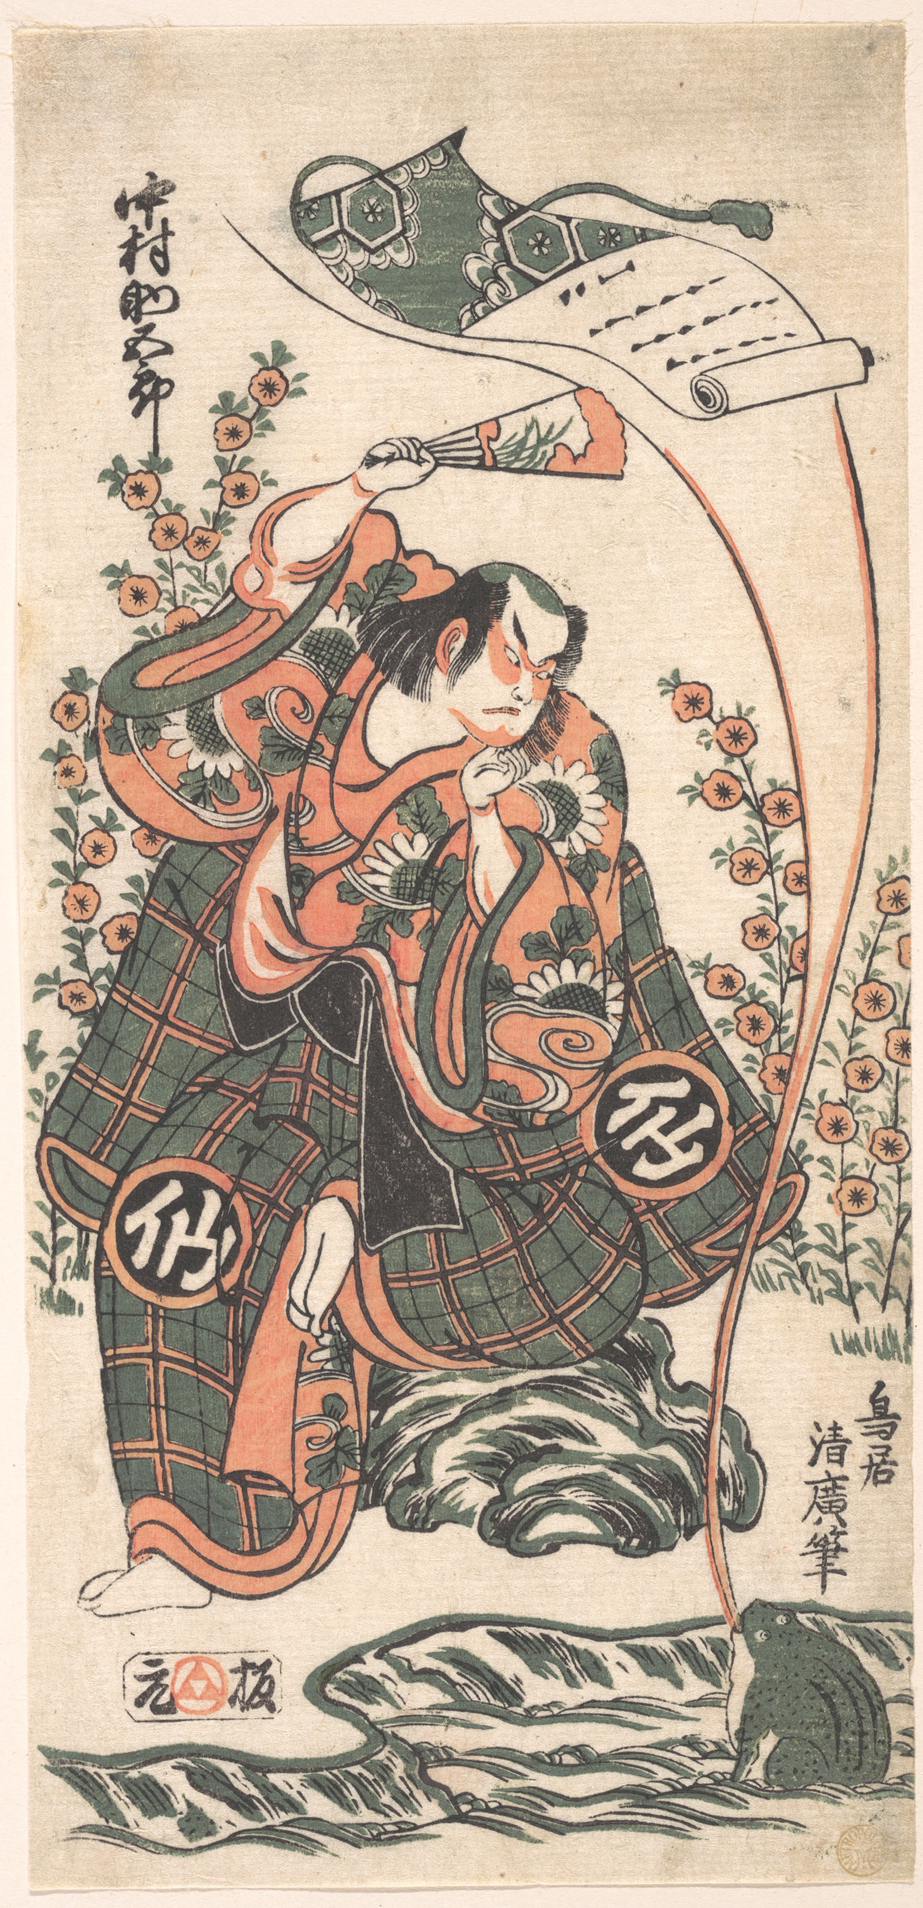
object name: print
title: The First Nakamura Sukegoro in the Role of Ōmi Kotōda in "Kiku wa Mukashi Soga-monogatari"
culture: japanese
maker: torii kiyohiro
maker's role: artist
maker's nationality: japanese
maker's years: 1737-1776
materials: ink, paper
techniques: woodblock print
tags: scrolls,fans,men,frogs,actors